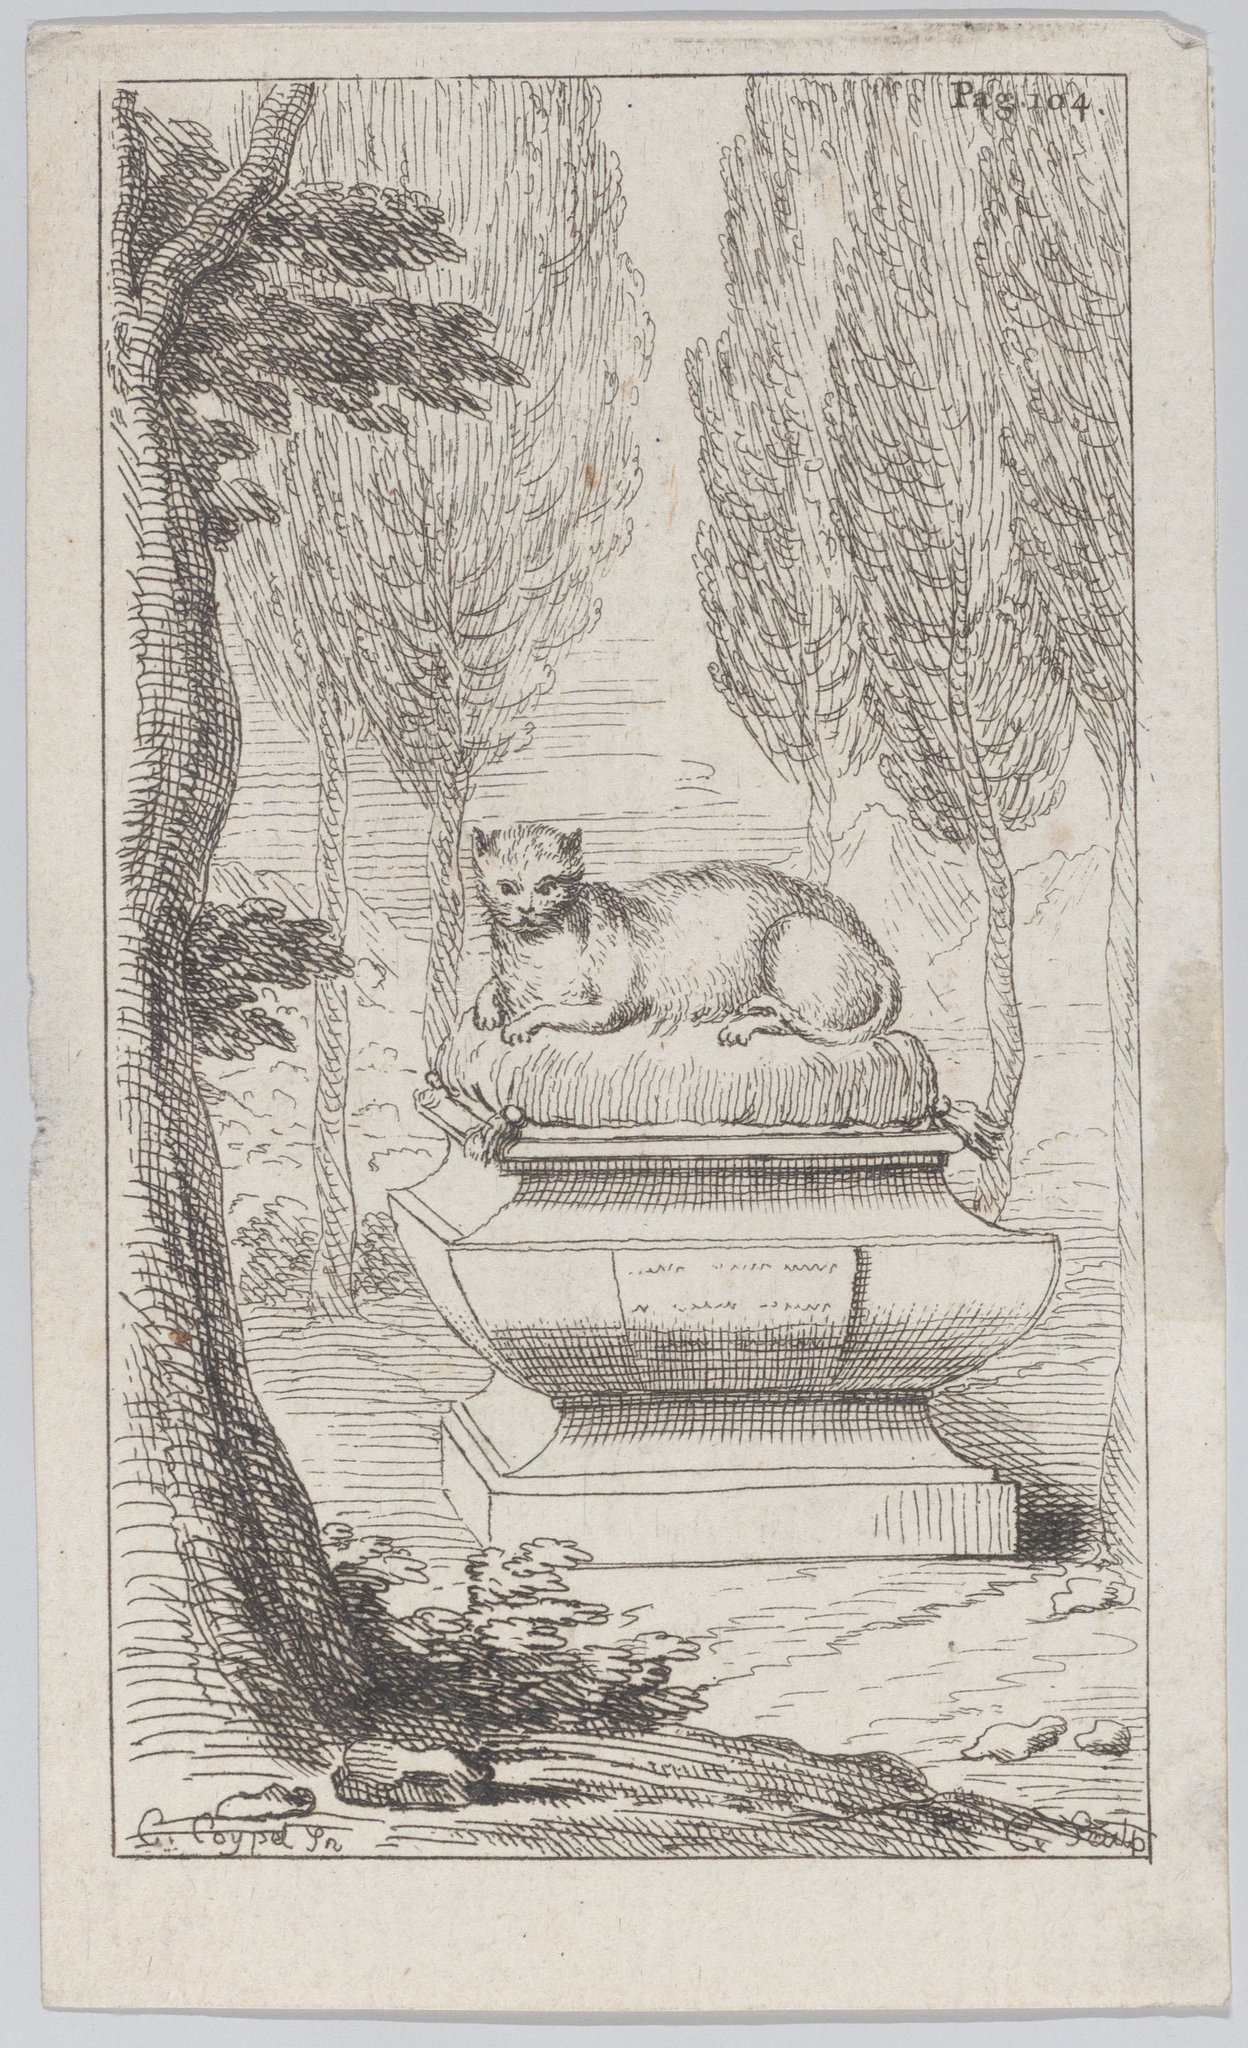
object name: print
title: Cat atop a tomb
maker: charles antoine coypel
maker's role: artist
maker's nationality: french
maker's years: 1694-1752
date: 1714-1752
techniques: etching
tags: tombs,cats